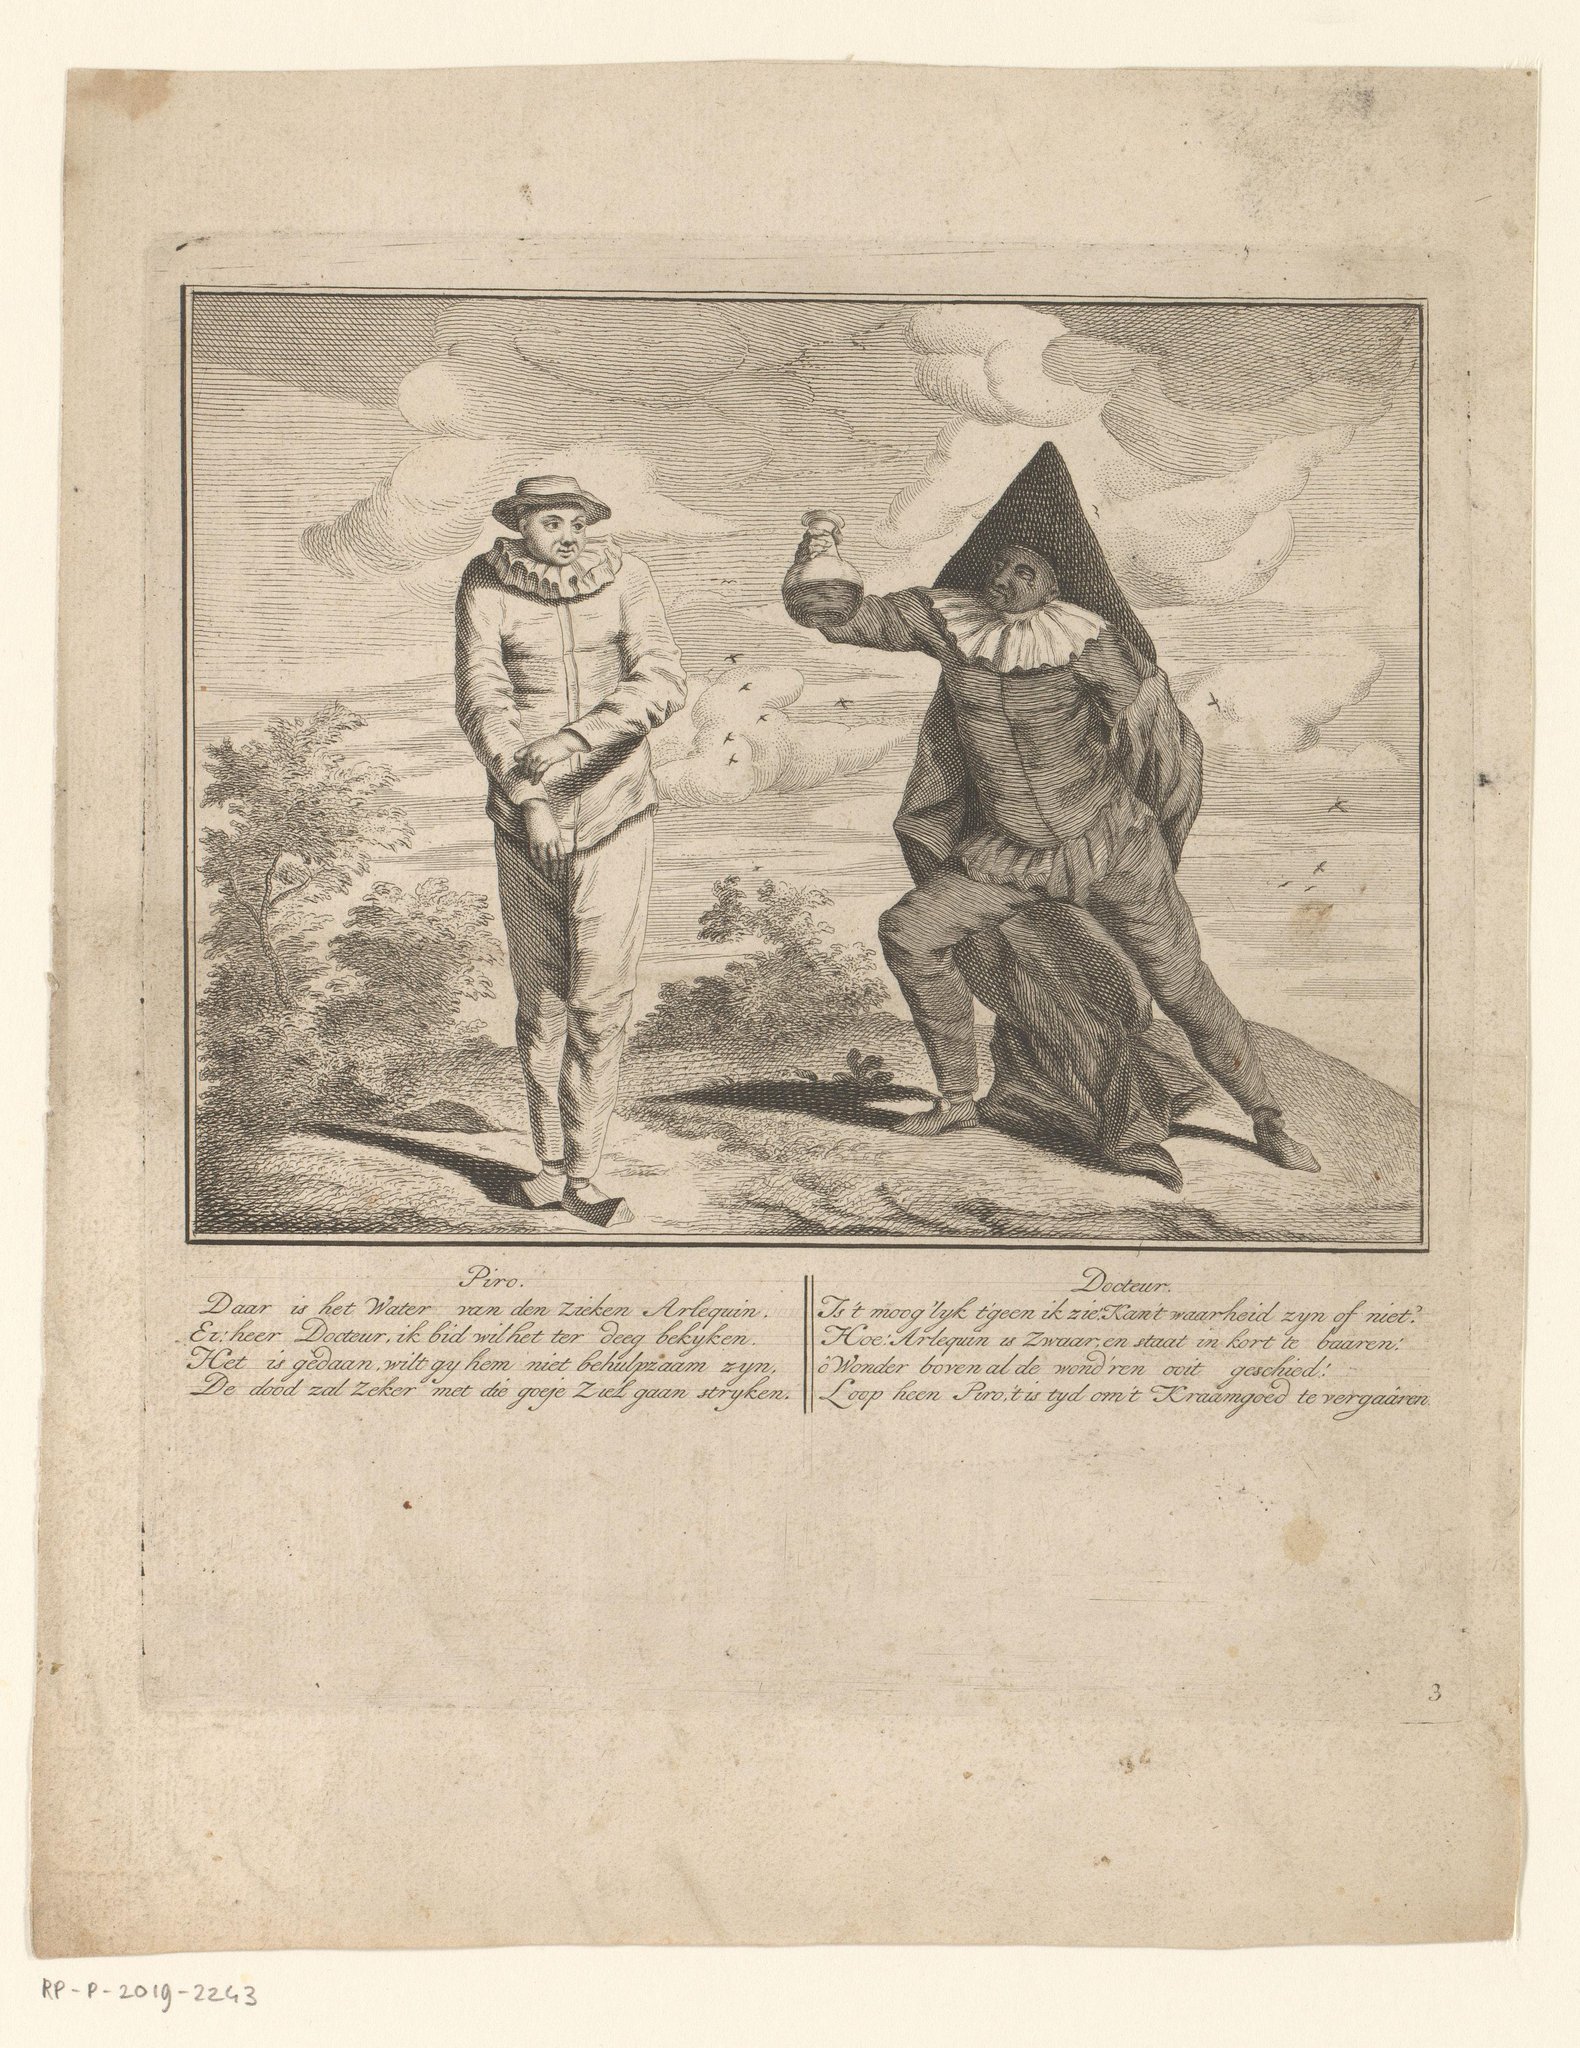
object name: print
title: Dokter onderzoekt de urine van Arlequin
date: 1720-1728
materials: paper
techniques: engraving, etching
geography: amsterdam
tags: types in 'commedia dell'arte', examination of urine, types in 'commedia dell'arte': harlequin, 'commedia dell'arte'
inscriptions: collector's mark: Lugt 2228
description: Piro heeft de dokter de urine van Arlequin gegeven om deze te onderzoeken. De dokter kijkt in de urinaal terwijl Piro afwacht.